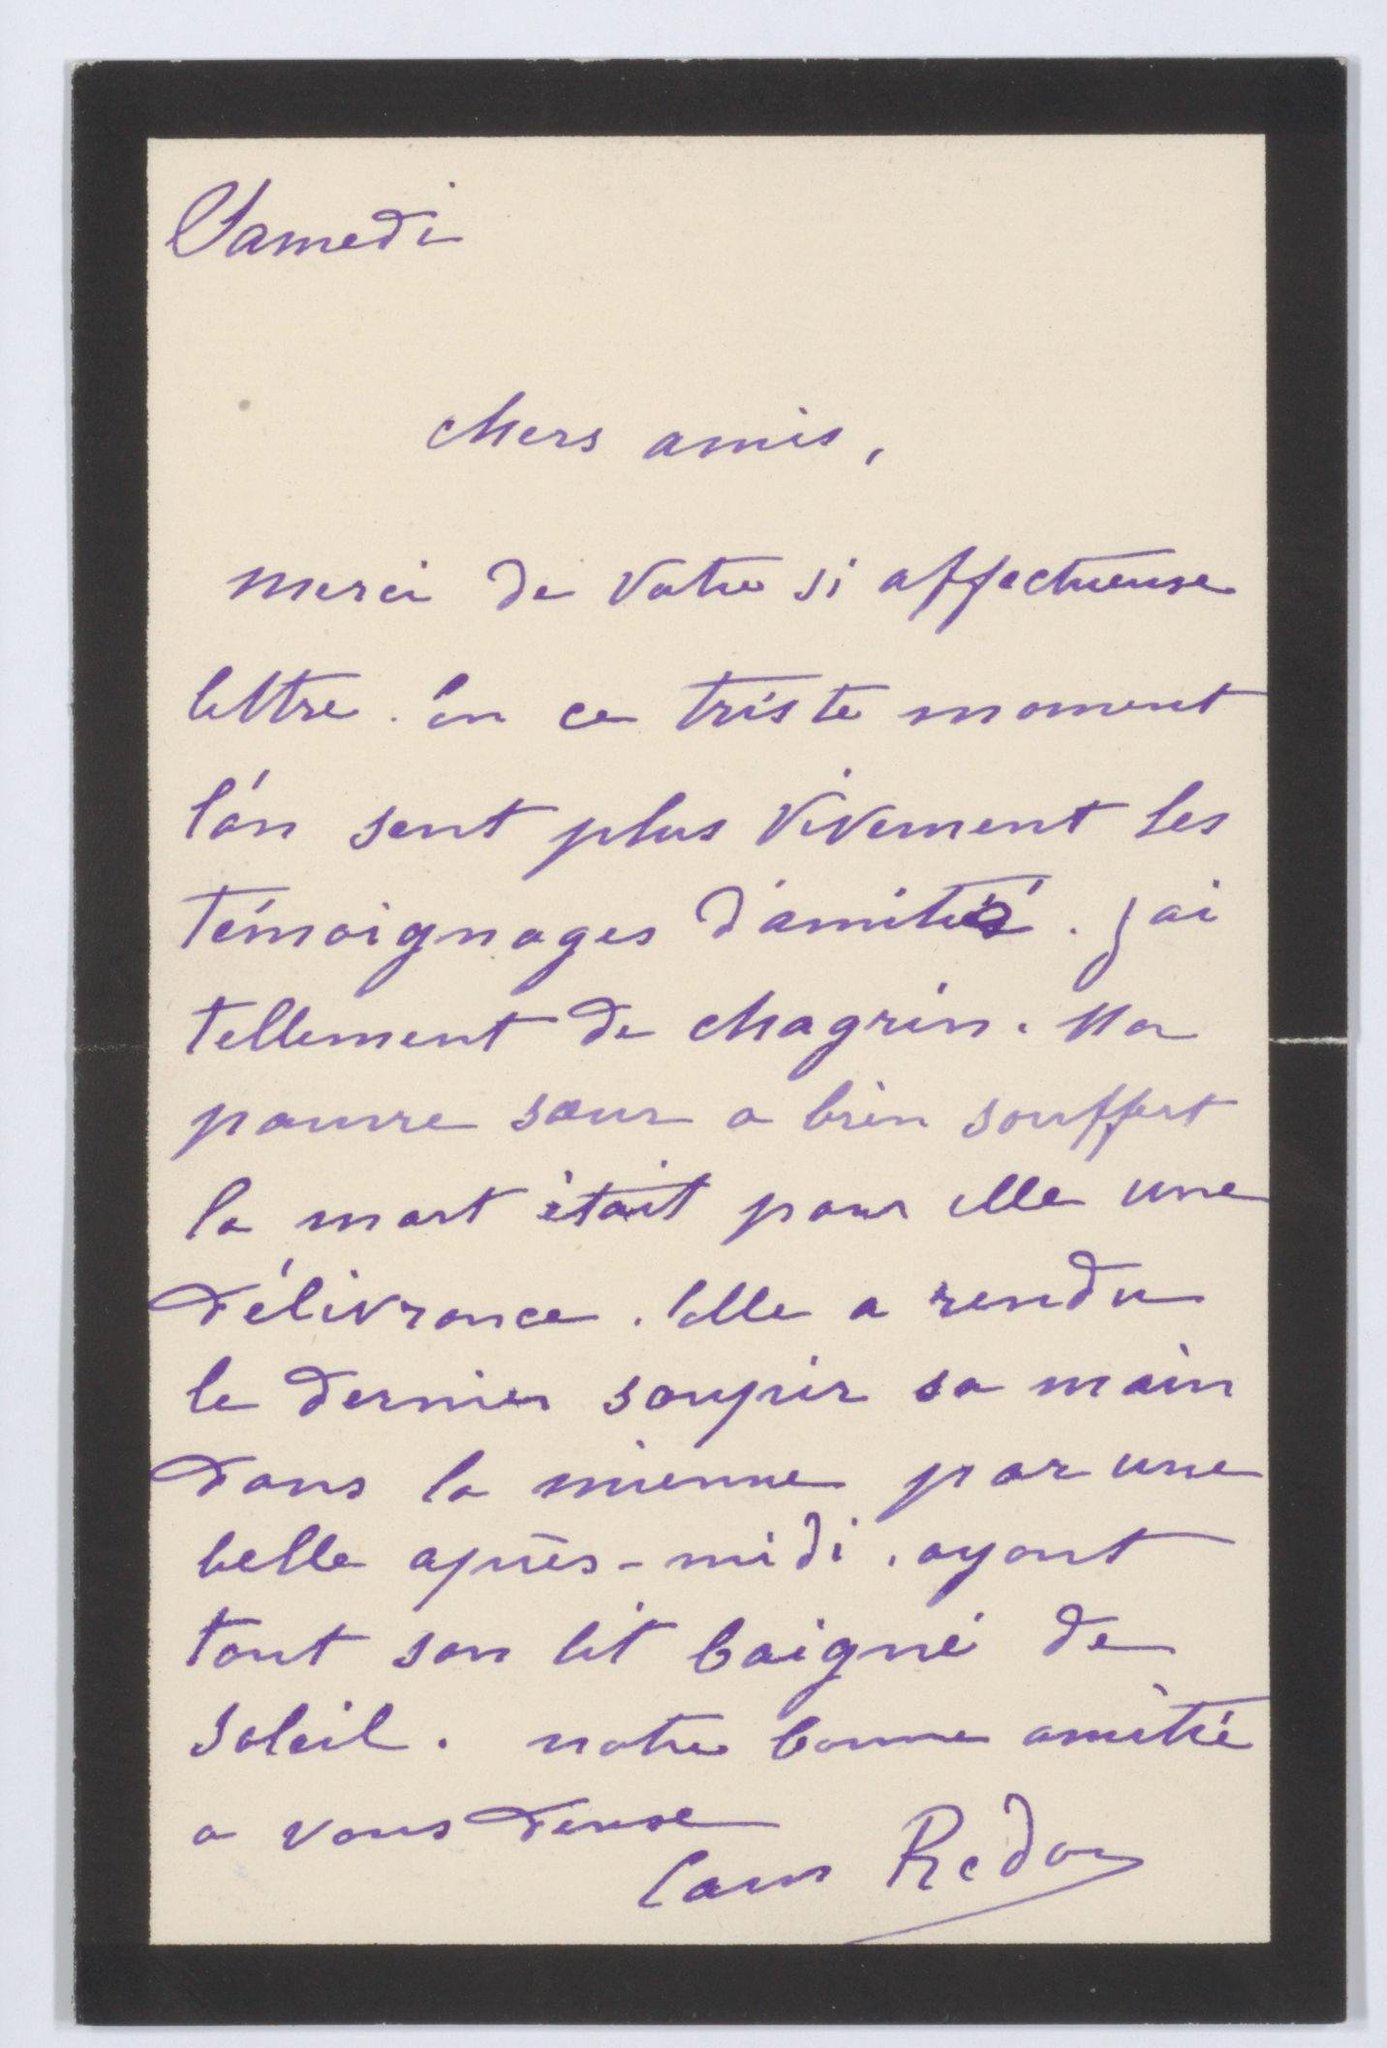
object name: letter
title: Brief aan Andries Bonger en Anne Marie Louise van der Linden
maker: camille redon-falte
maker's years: 1853-1923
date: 1909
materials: ink, paper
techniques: pen, writing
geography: paris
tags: amsterdam, andries bonger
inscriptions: watermark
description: Brief behoort tot een album samengesteld door weduwe Françoise W.M. Barones van der Borch van Verwolde met afschriften van brieven met betrekking tot (de familie van) Odilon Redon. De brief werd bewaard op pagina 161.